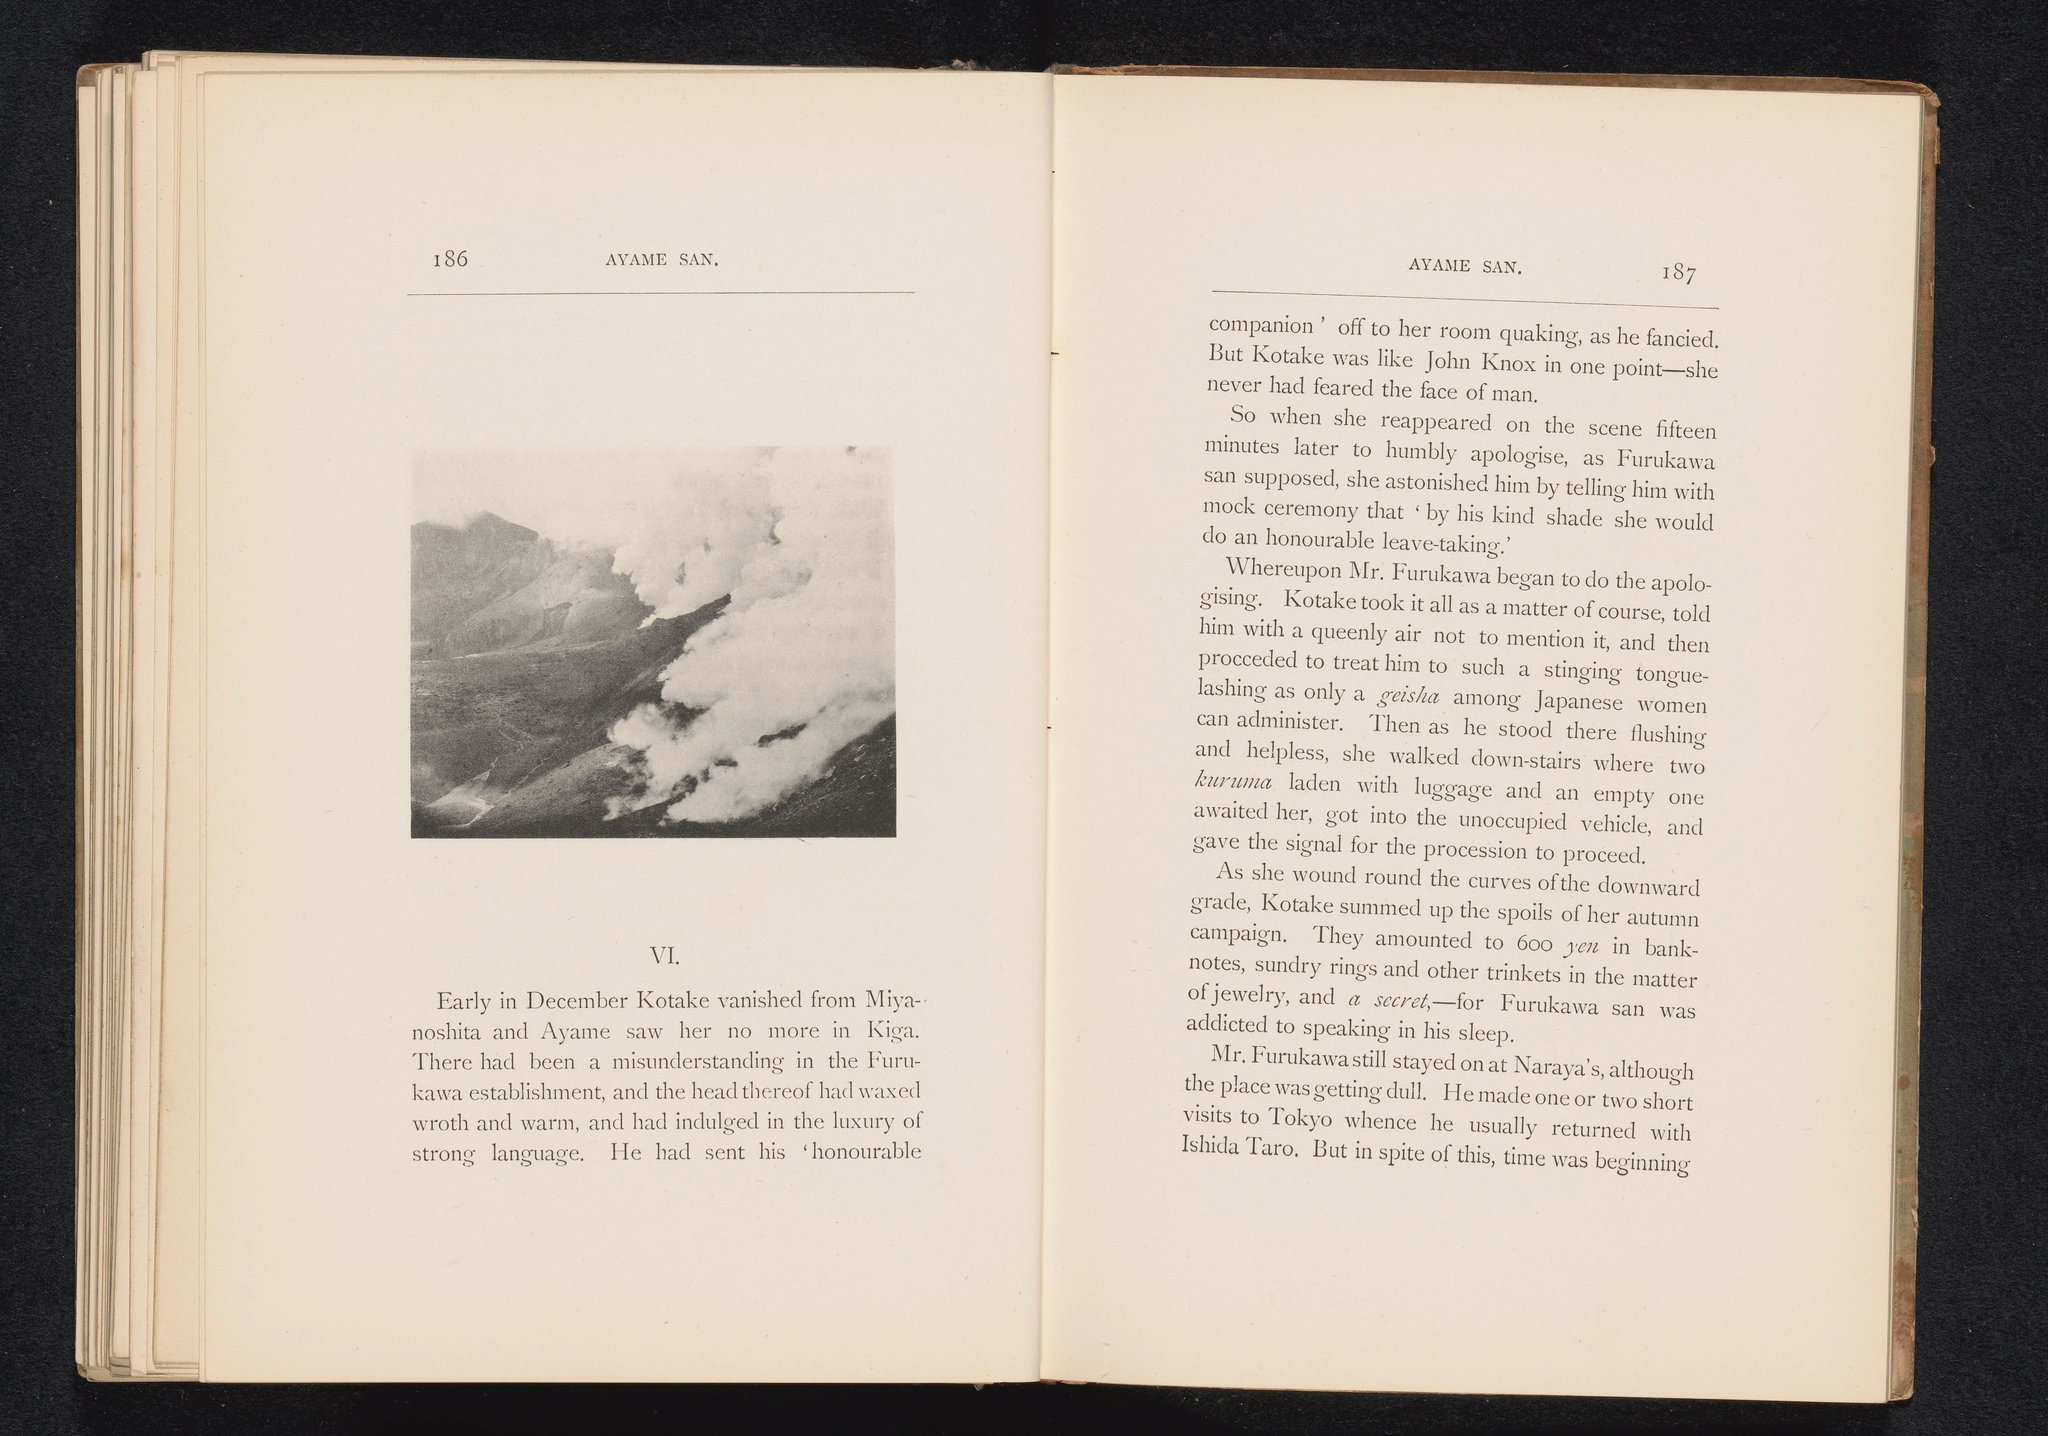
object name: photomechanical print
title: Gezicht op (vermoedelijk) de helling van een vulkaan te Japan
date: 1882-1892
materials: paper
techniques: photograph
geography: japan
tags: smoke, volcano